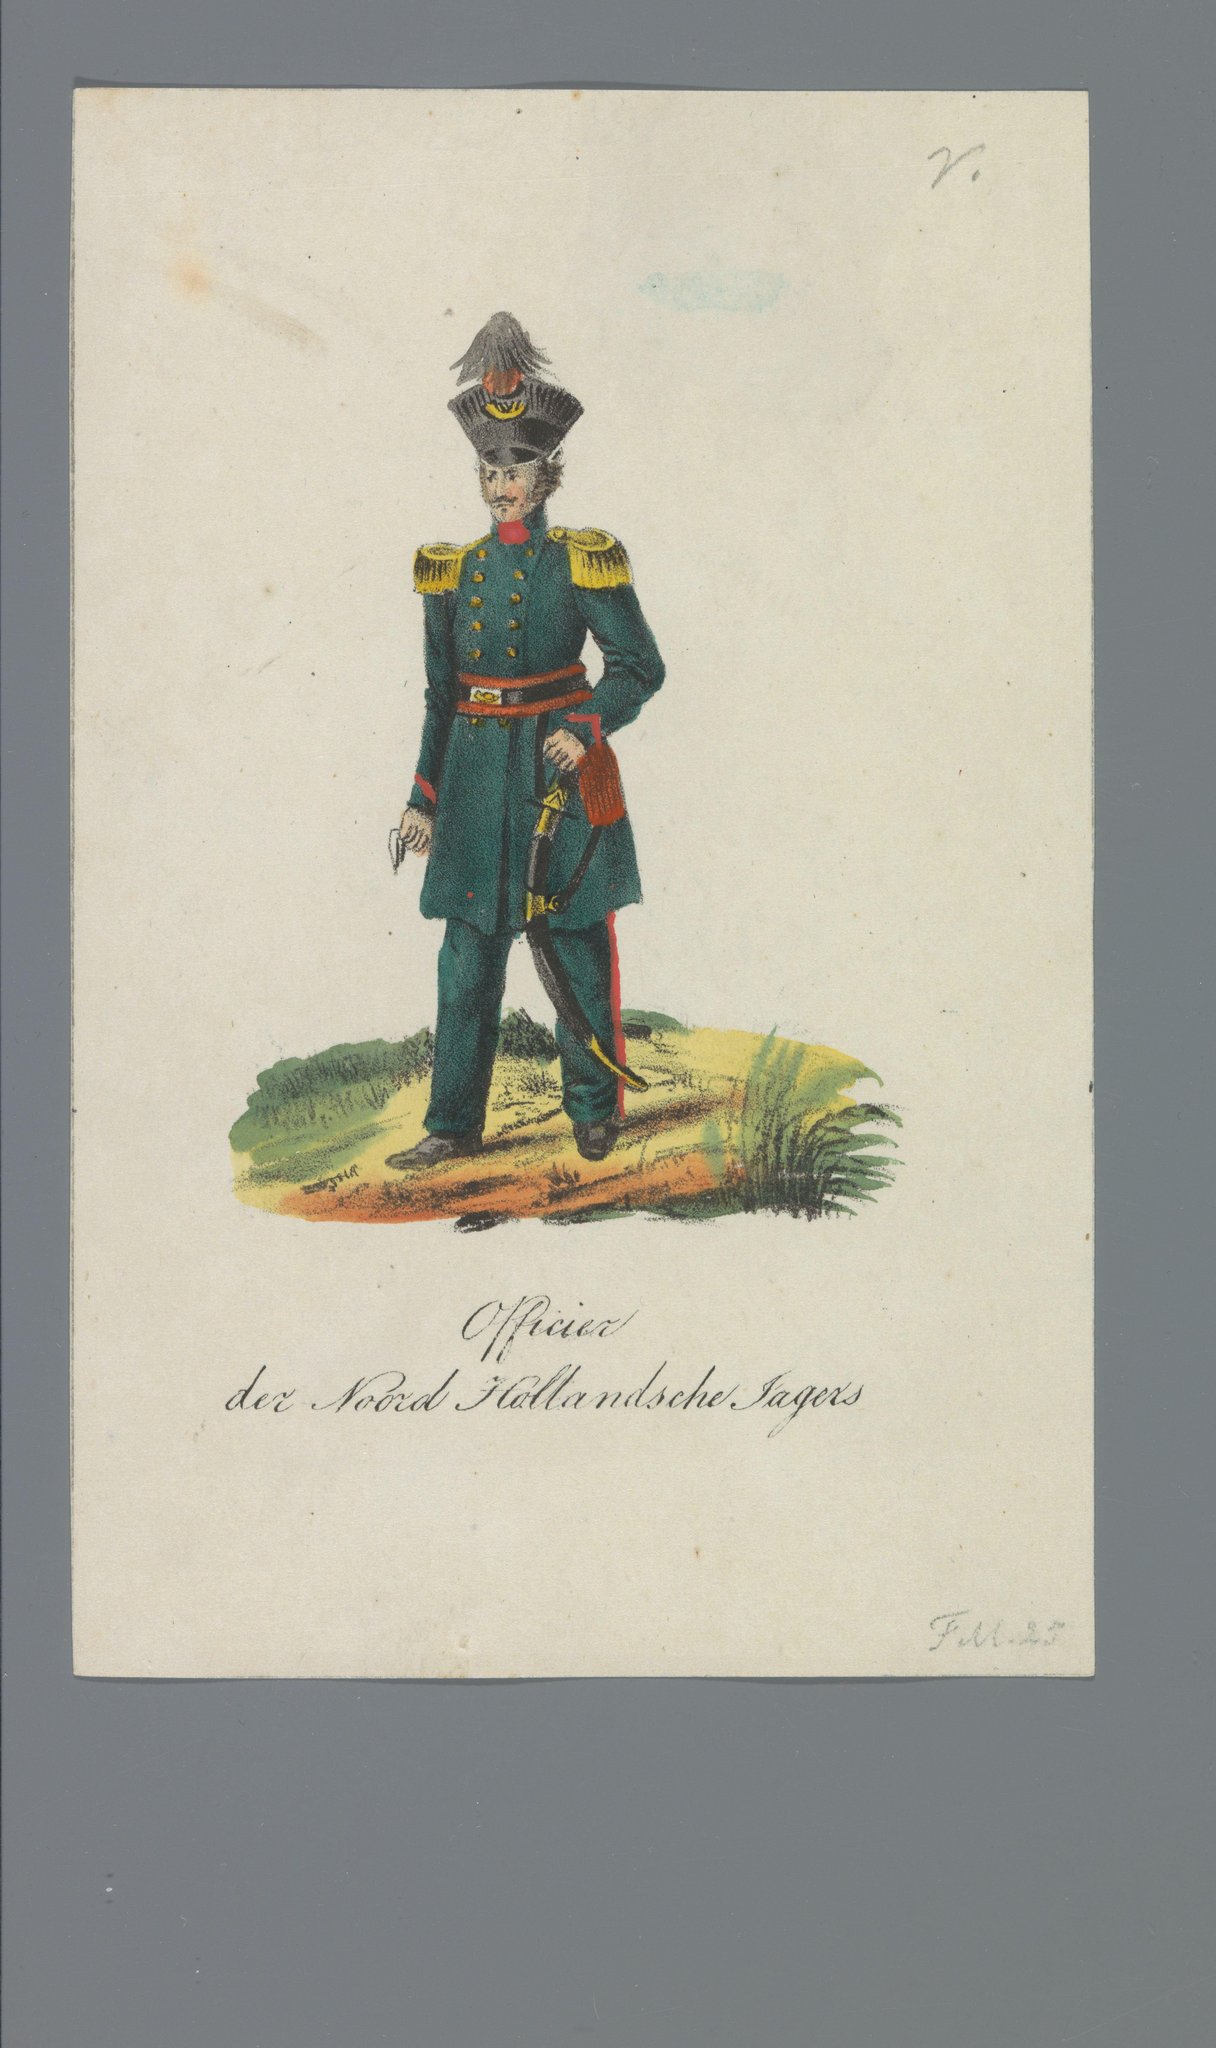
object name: print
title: Nederlandse militaire uniformen in de jaren 1830-1832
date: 1835-1850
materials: paper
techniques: hand coloring, lithograph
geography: utrecht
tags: (military) uniforms, clothes, costume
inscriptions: collector's mark: Lugt 2228, collector's mark: Lugt 2227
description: Staande officier van het Korps Noord-Hollandse Jagers. Onderdeel van een serie van 157 losse bladen met Nederlandse militaire uniformen in de jaren 1830-1832.